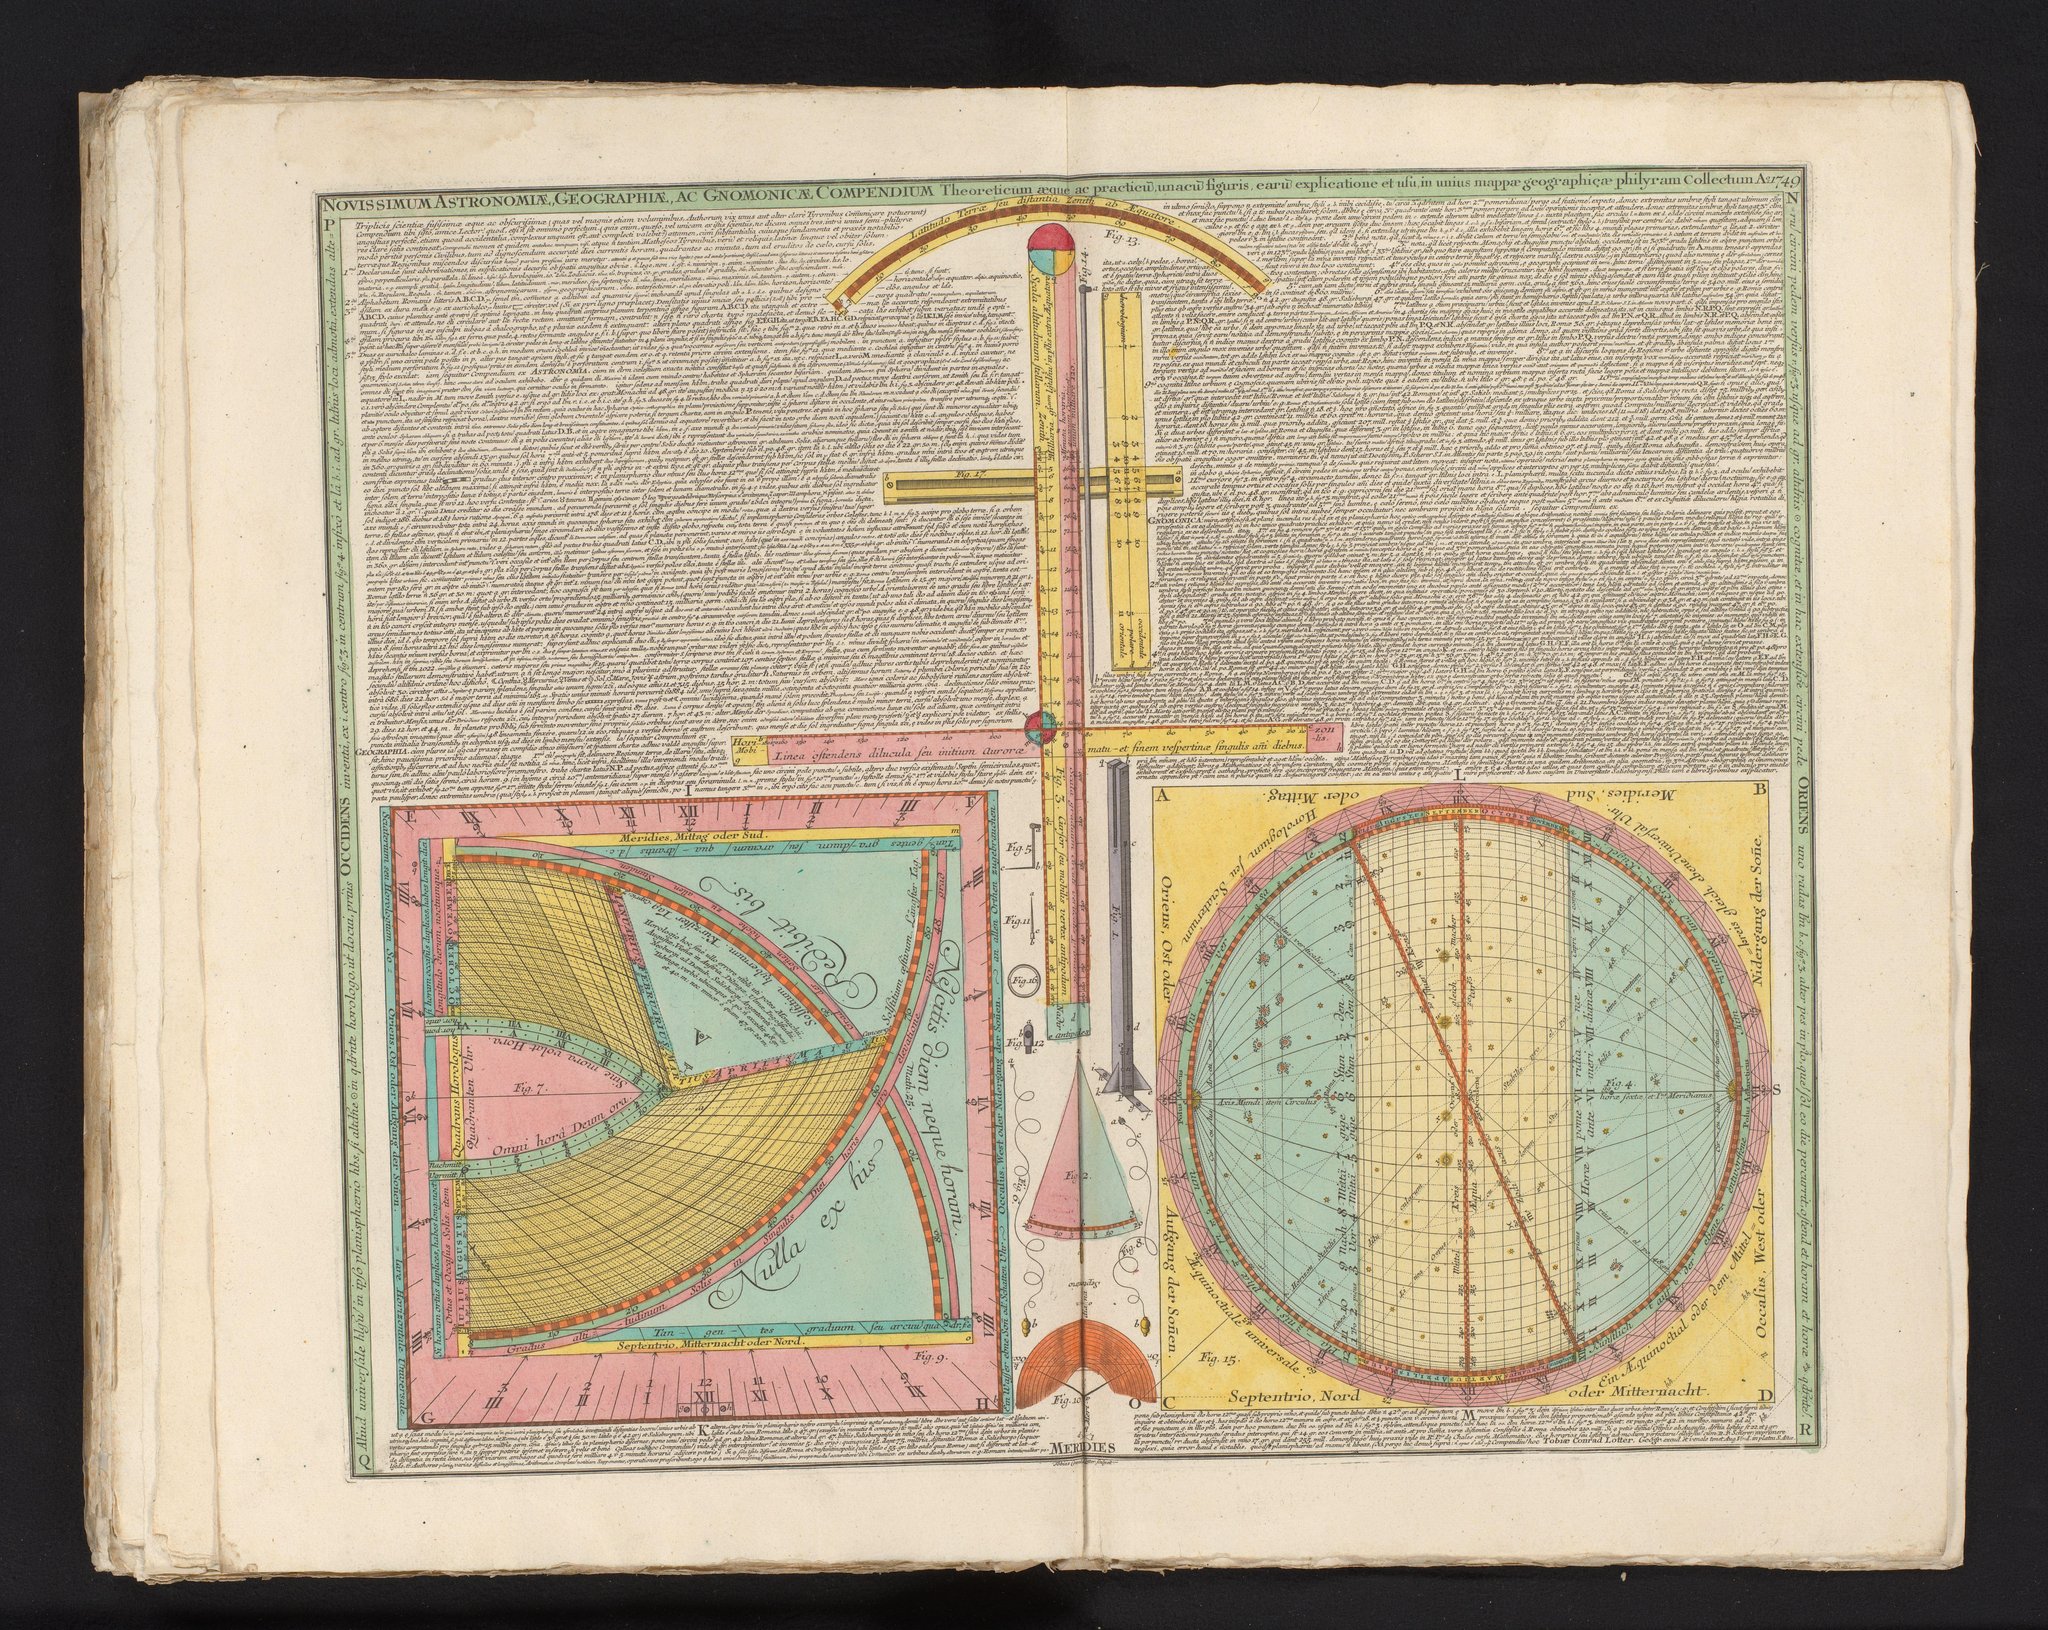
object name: print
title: Astronomische theorieën en uitleg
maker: tobias conrad lotter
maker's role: publisher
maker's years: 1717-1777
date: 1749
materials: paper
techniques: engraving, hand coloring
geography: augsburg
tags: astronomy (and cosmography)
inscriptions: date